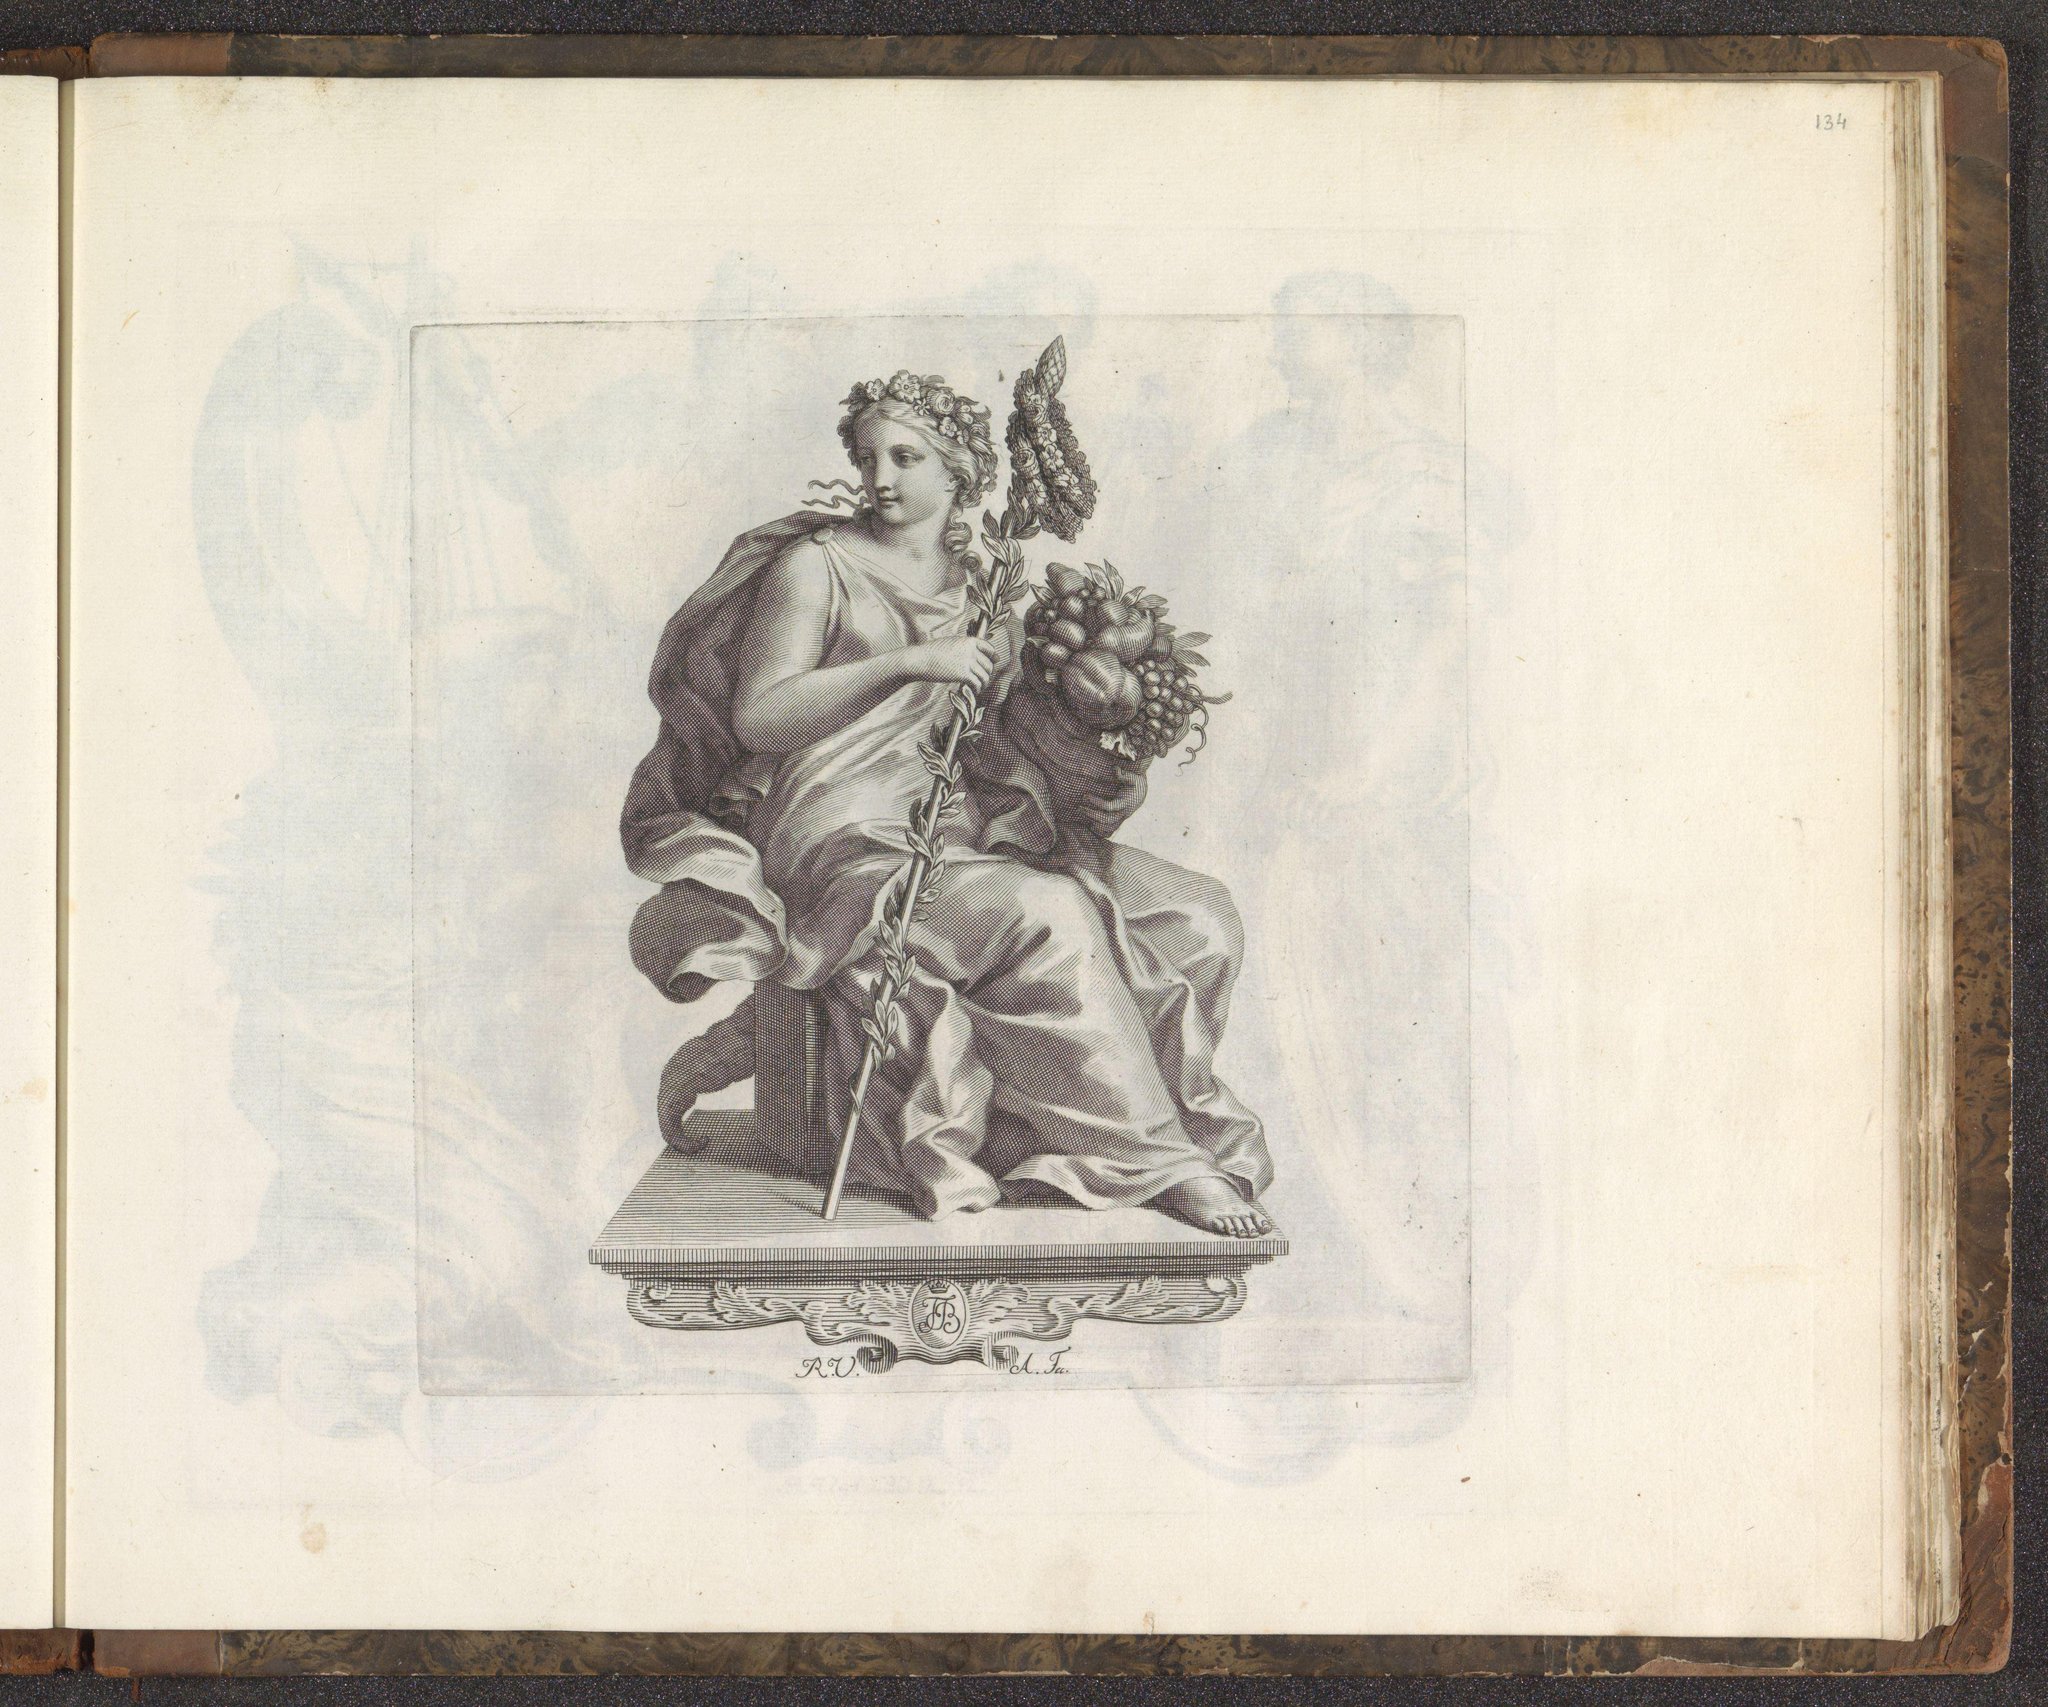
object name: print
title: Numismata virorum illustrium ex Barbadica gente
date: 1673-1743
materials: paper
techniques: engraving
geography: rome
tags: thyrsus ~ attribute of bacchus, pleasure, enjoyment, joy; 'allegrezza', 'allegrezza da le medaglie', 'allegrezza, letitia e giubilo', 'diletto', 'piacere', 'piacere honesto' (ripa)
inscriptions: collector's mark: Lugt 2228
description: Een console met een zittende vrouw. In het haar een bloemenkrans. In haar handen een hoorn des overvloeds en een thyrsus, een staf met een knop in de vorm van een dennenappel. De stad is omwikkeld met bladeren en er hangen twee kransen aan. De prent maakt deel uit van een album.